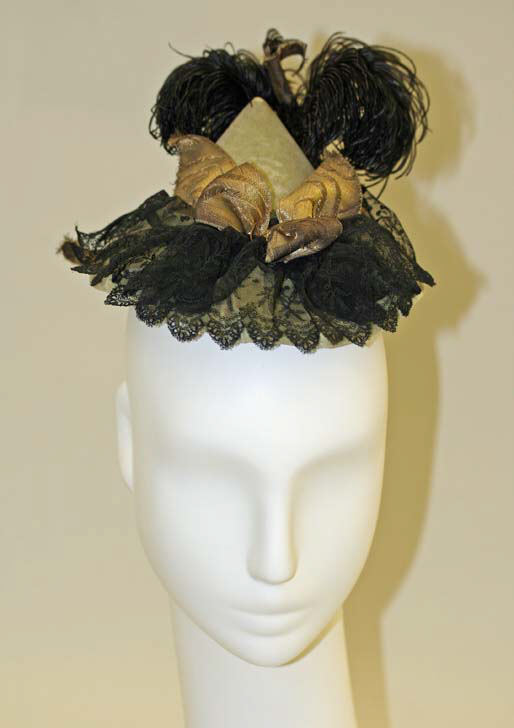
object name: hat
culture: american or european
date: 1892